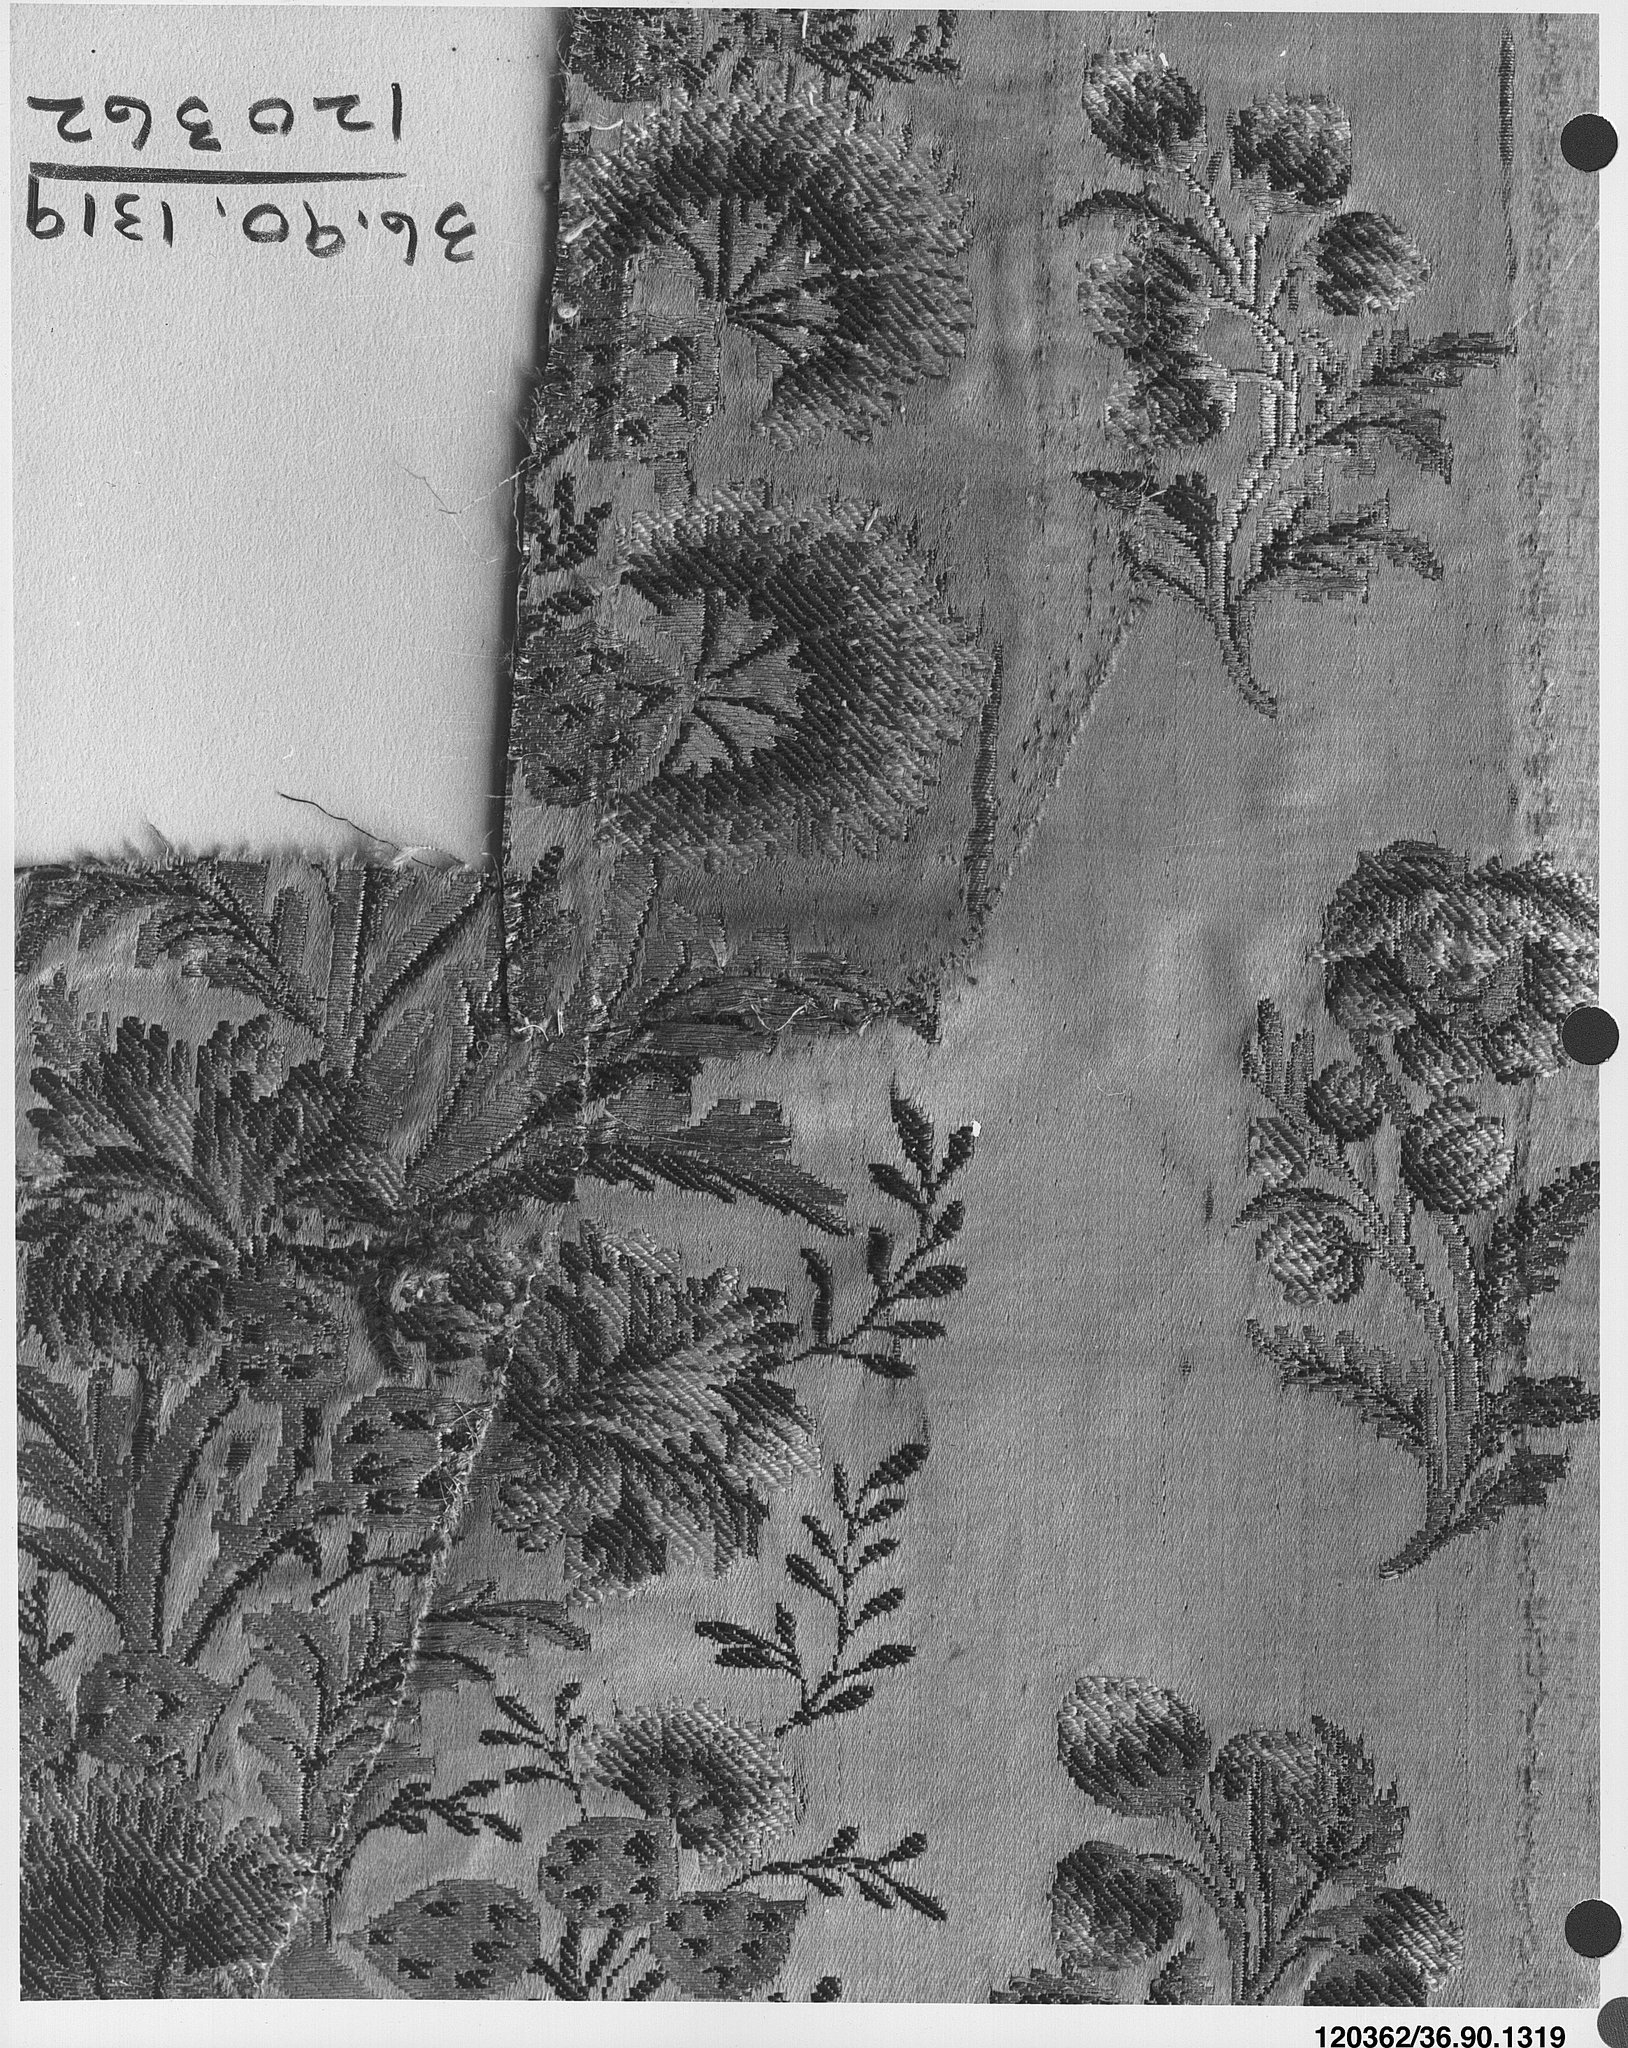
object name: piece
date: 1745-1750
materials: metal thread, silk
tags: flowers,leaves